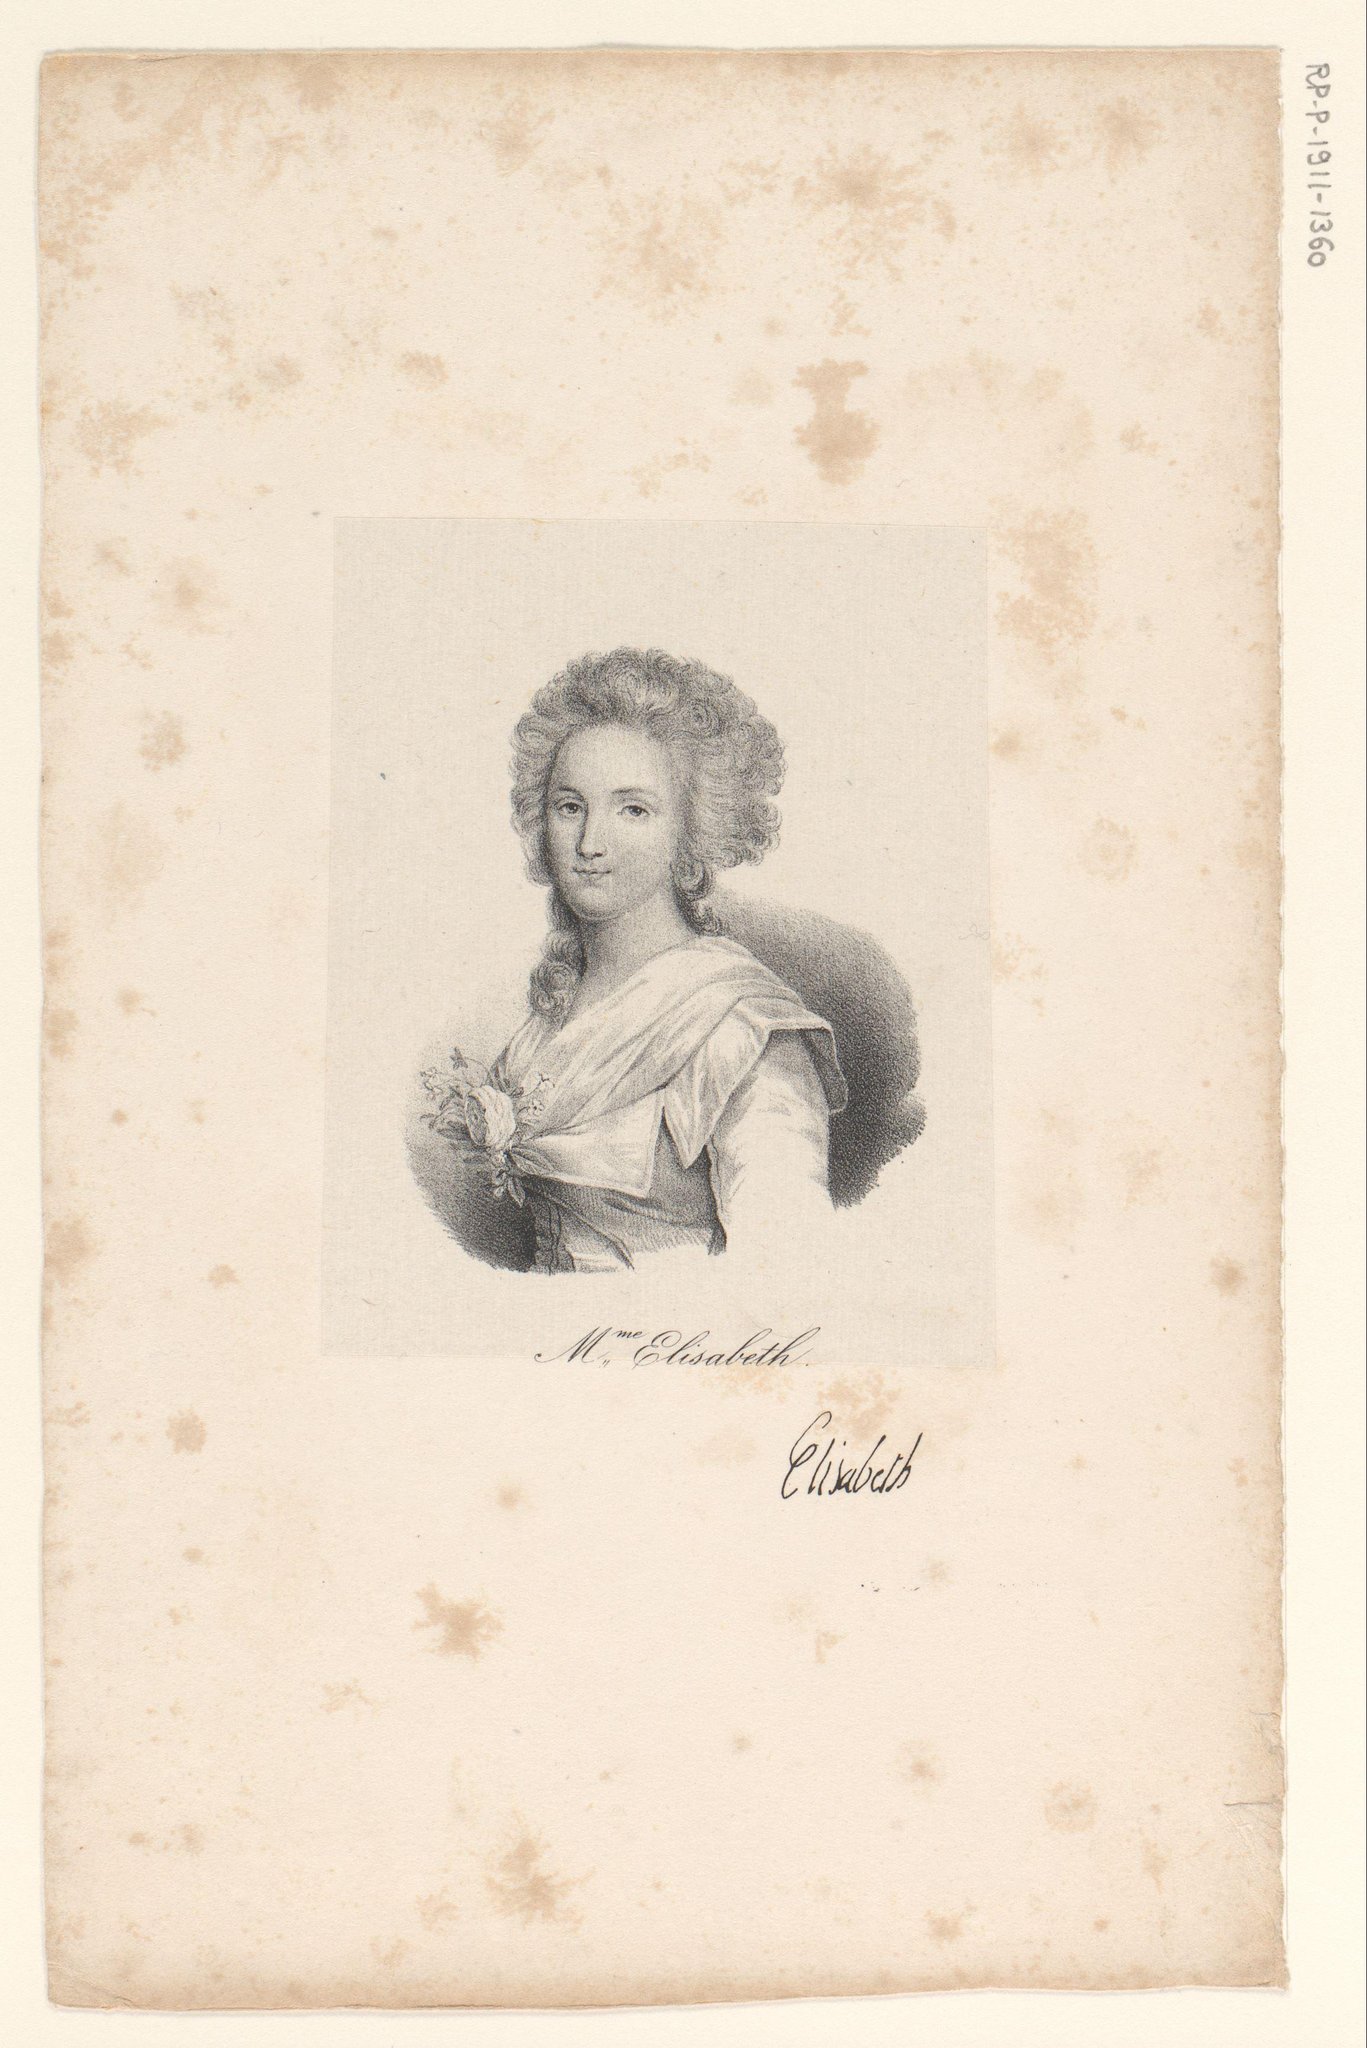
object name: print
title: Portret van Elisabeth van Frankrijk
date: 1818-1842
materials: paper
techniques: lithograph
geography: paris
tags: paris, historical persons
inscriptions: collector's mark: Lugt 2228a